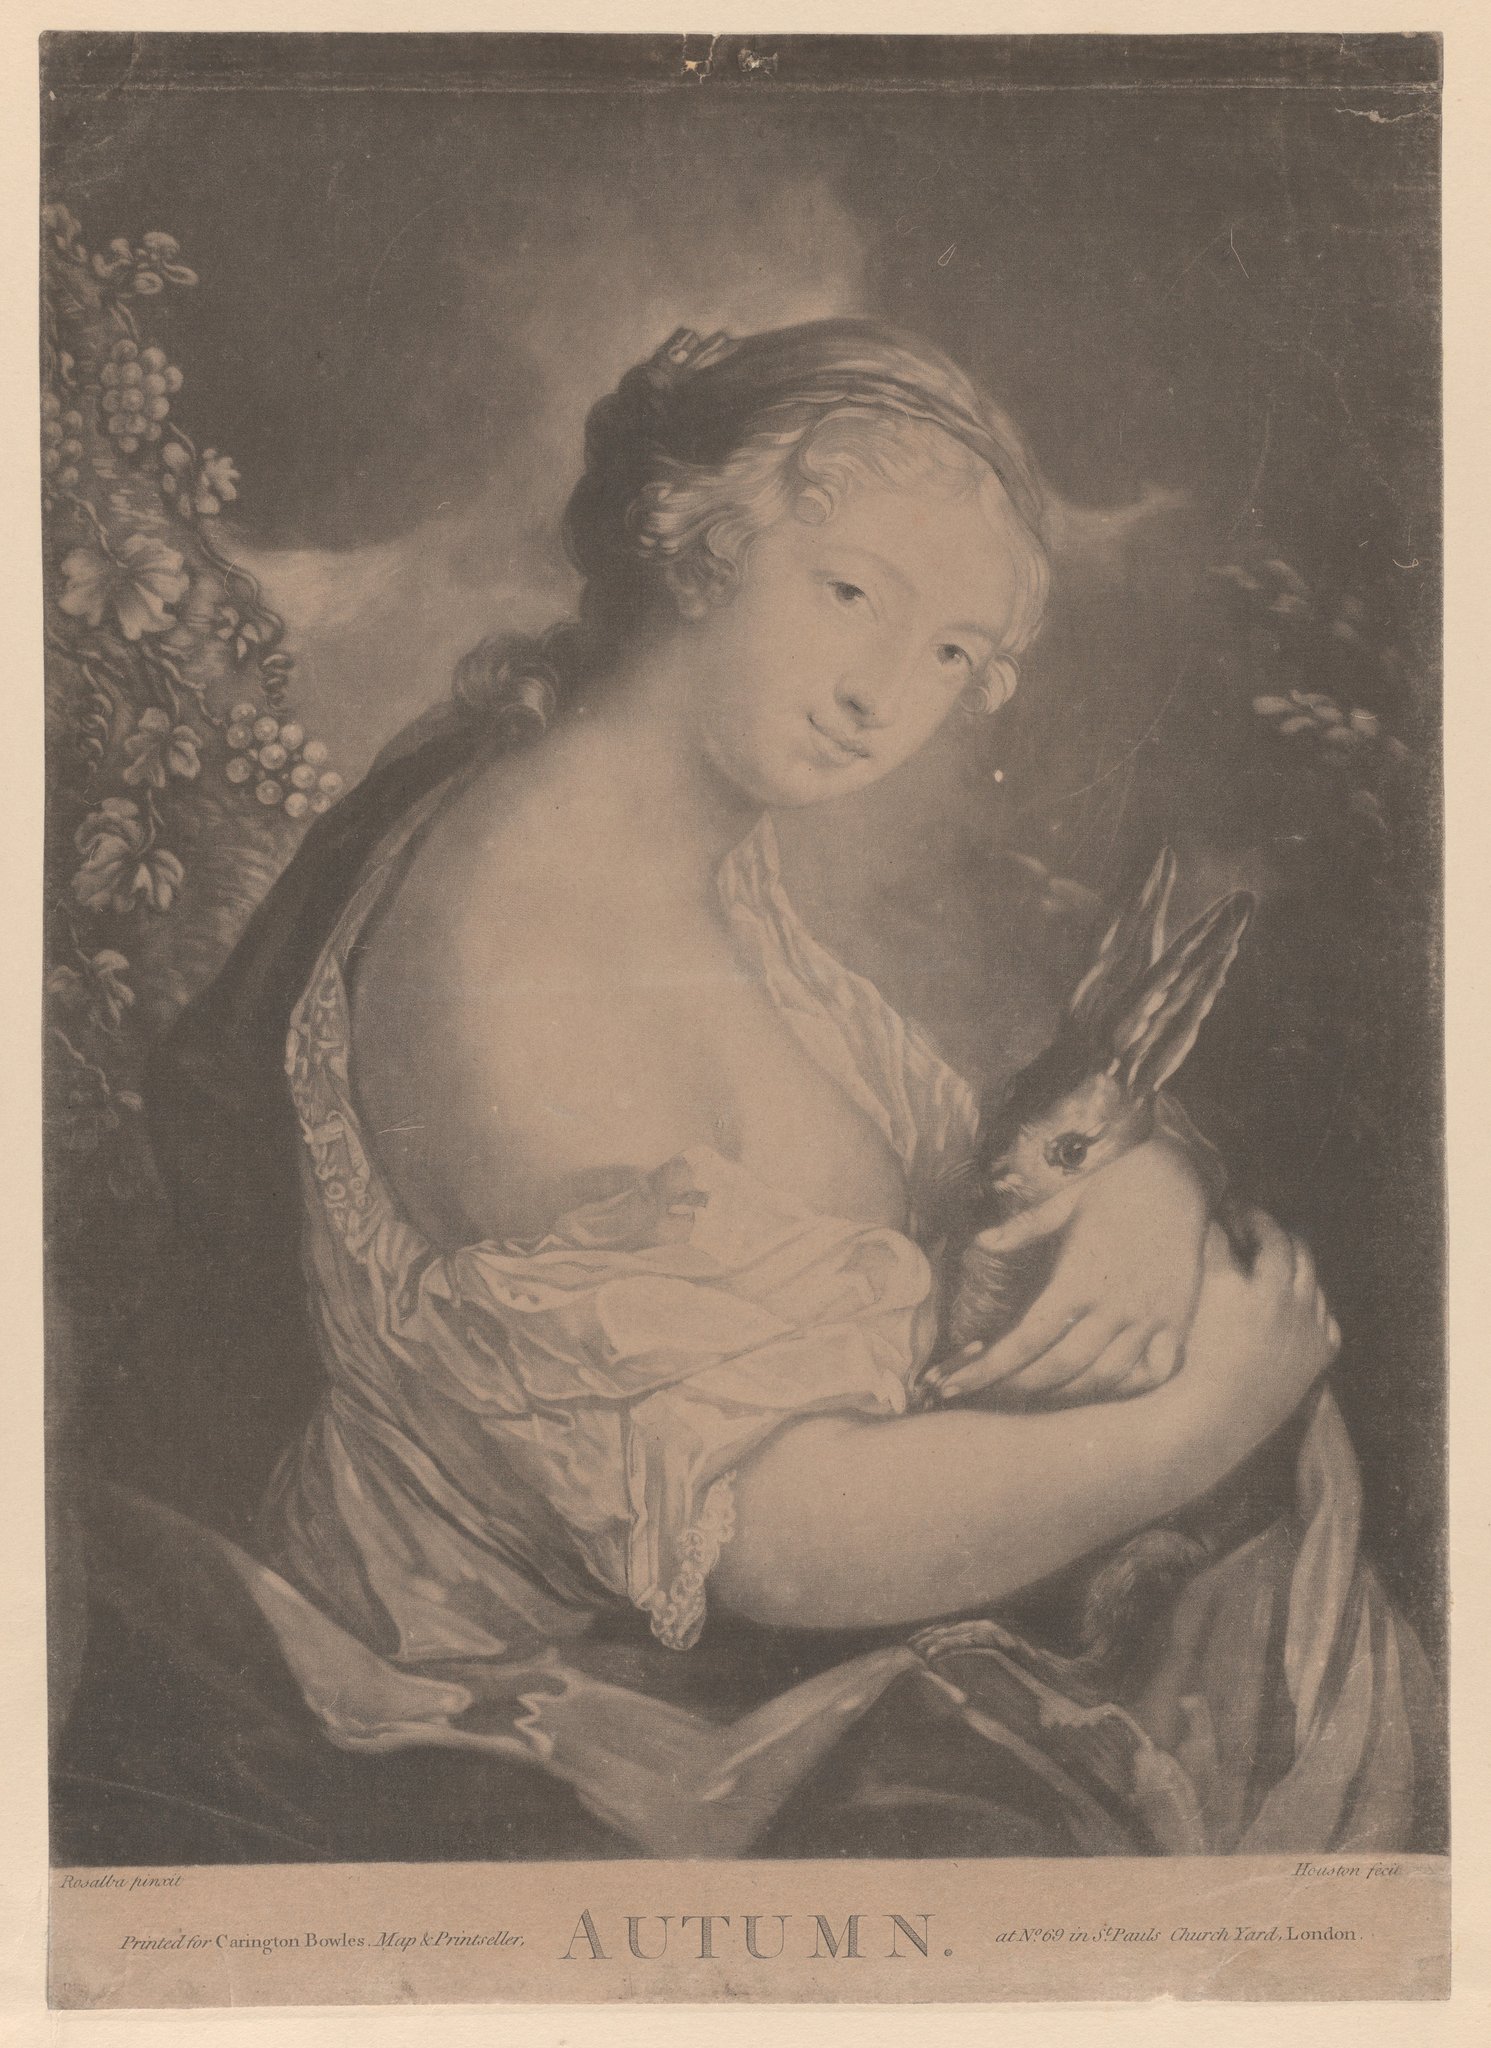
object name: print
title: Autumn: a young woman holding a rabbit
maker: richard houston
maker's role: artist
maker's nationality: irish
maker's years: 1721-1775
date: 1775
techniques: mezzotint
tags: women,rabbits